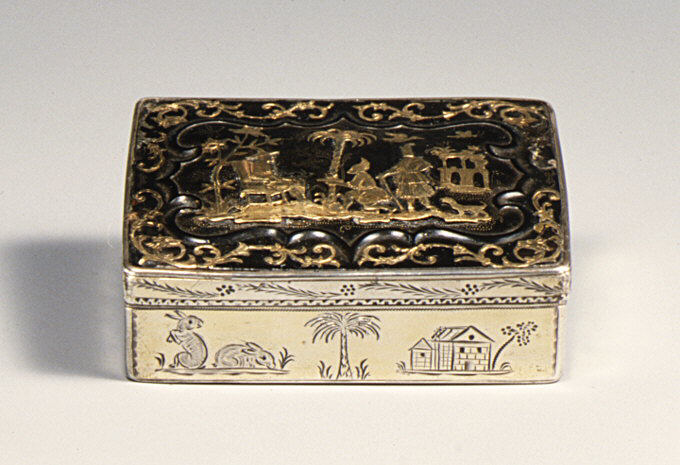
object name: box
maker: wilhelm krüger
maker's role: artist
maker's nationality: german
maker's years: 1680-1756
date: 1701-1800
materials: silver gilt, shell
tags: human figures,buildings,rabbits,trees